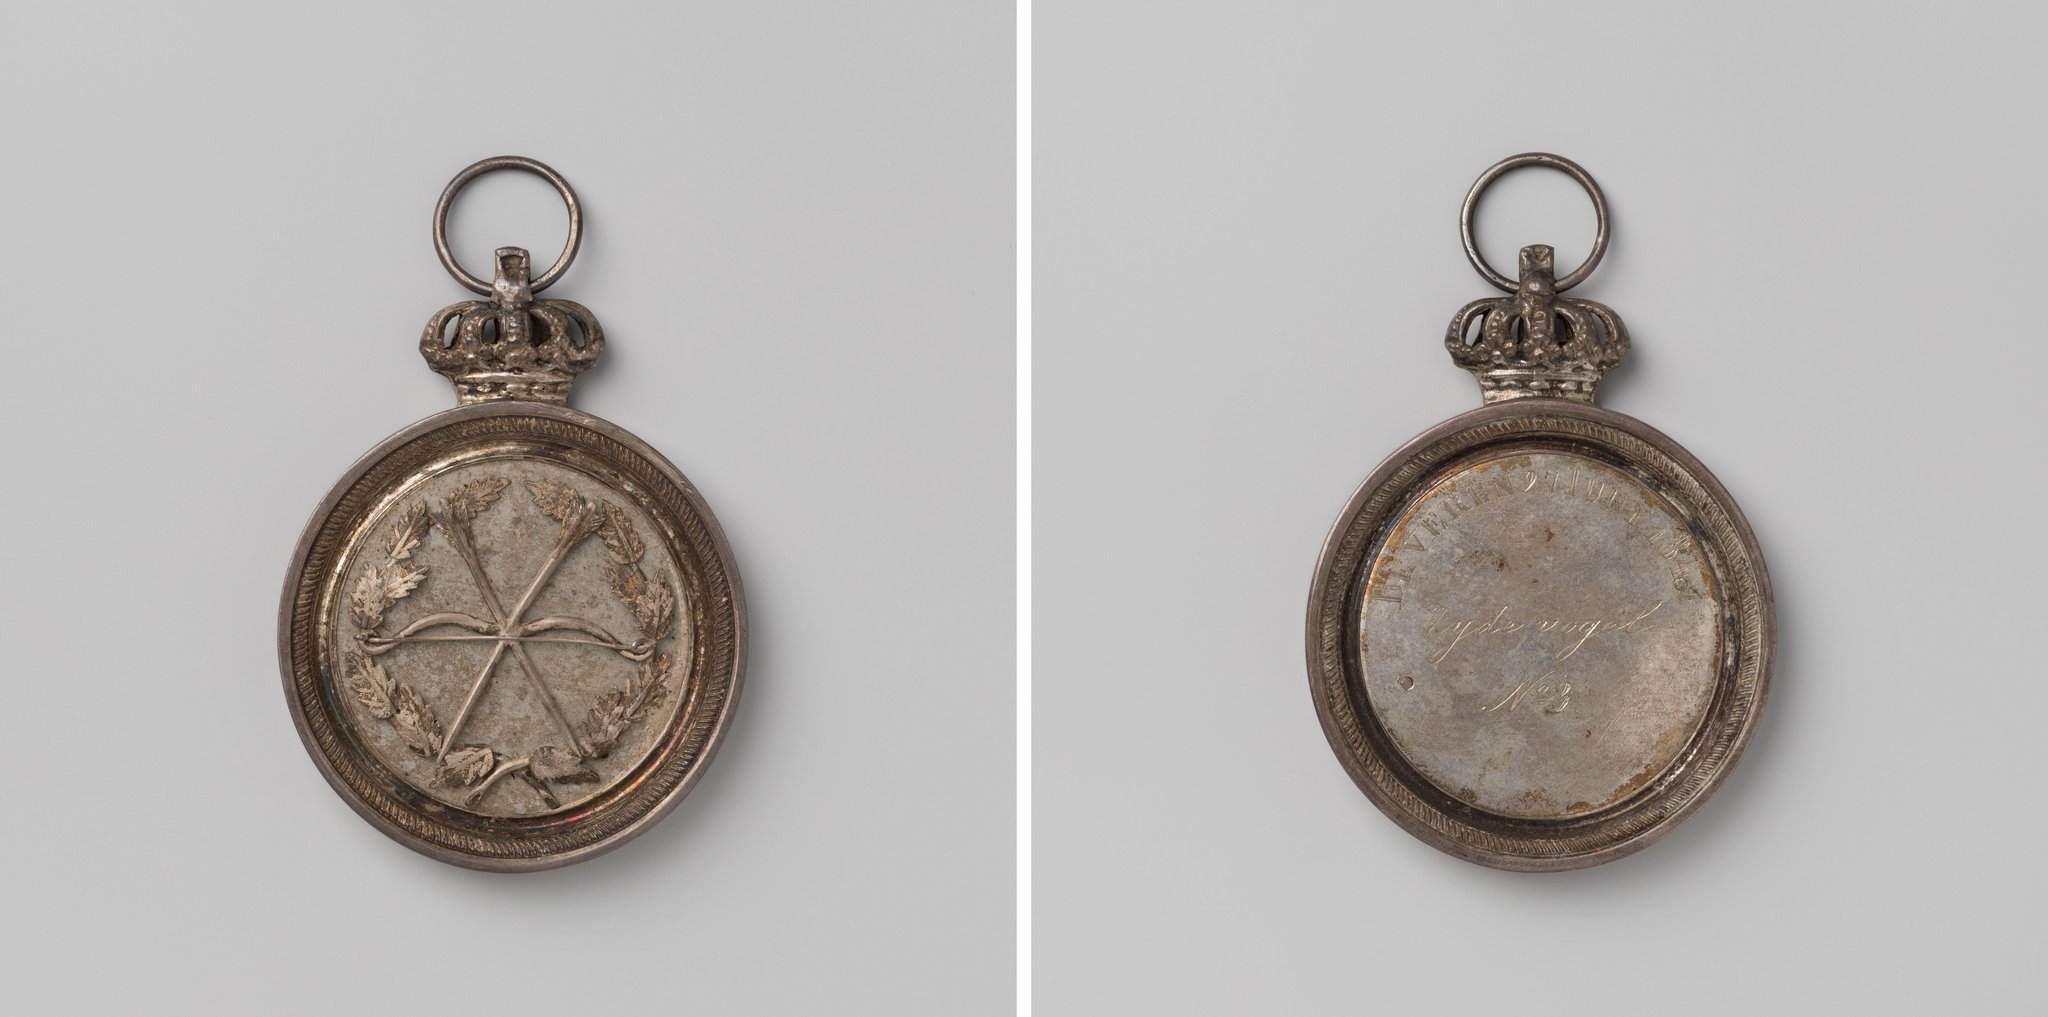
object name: medal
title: Gaaischieten te Beveren, penning met opschrift 'zijde vogel No. 3'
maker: Anonymous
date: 1847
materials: silver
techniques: casting, engraving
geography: belgium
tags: beveren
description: Zilveren penning bestaande uit twee ronde plaatjes gevat in ring, bevestigd aan opengewerkte kroon aan draagring. Voorzijde: in relief: twee gekruiste pijlen op boog binnen eikekrans. Keerzijde: opschrift binnen omschrift; in veld keerzijde twee nagels, waarmee beide zijden aan elkaar zijn gezet.